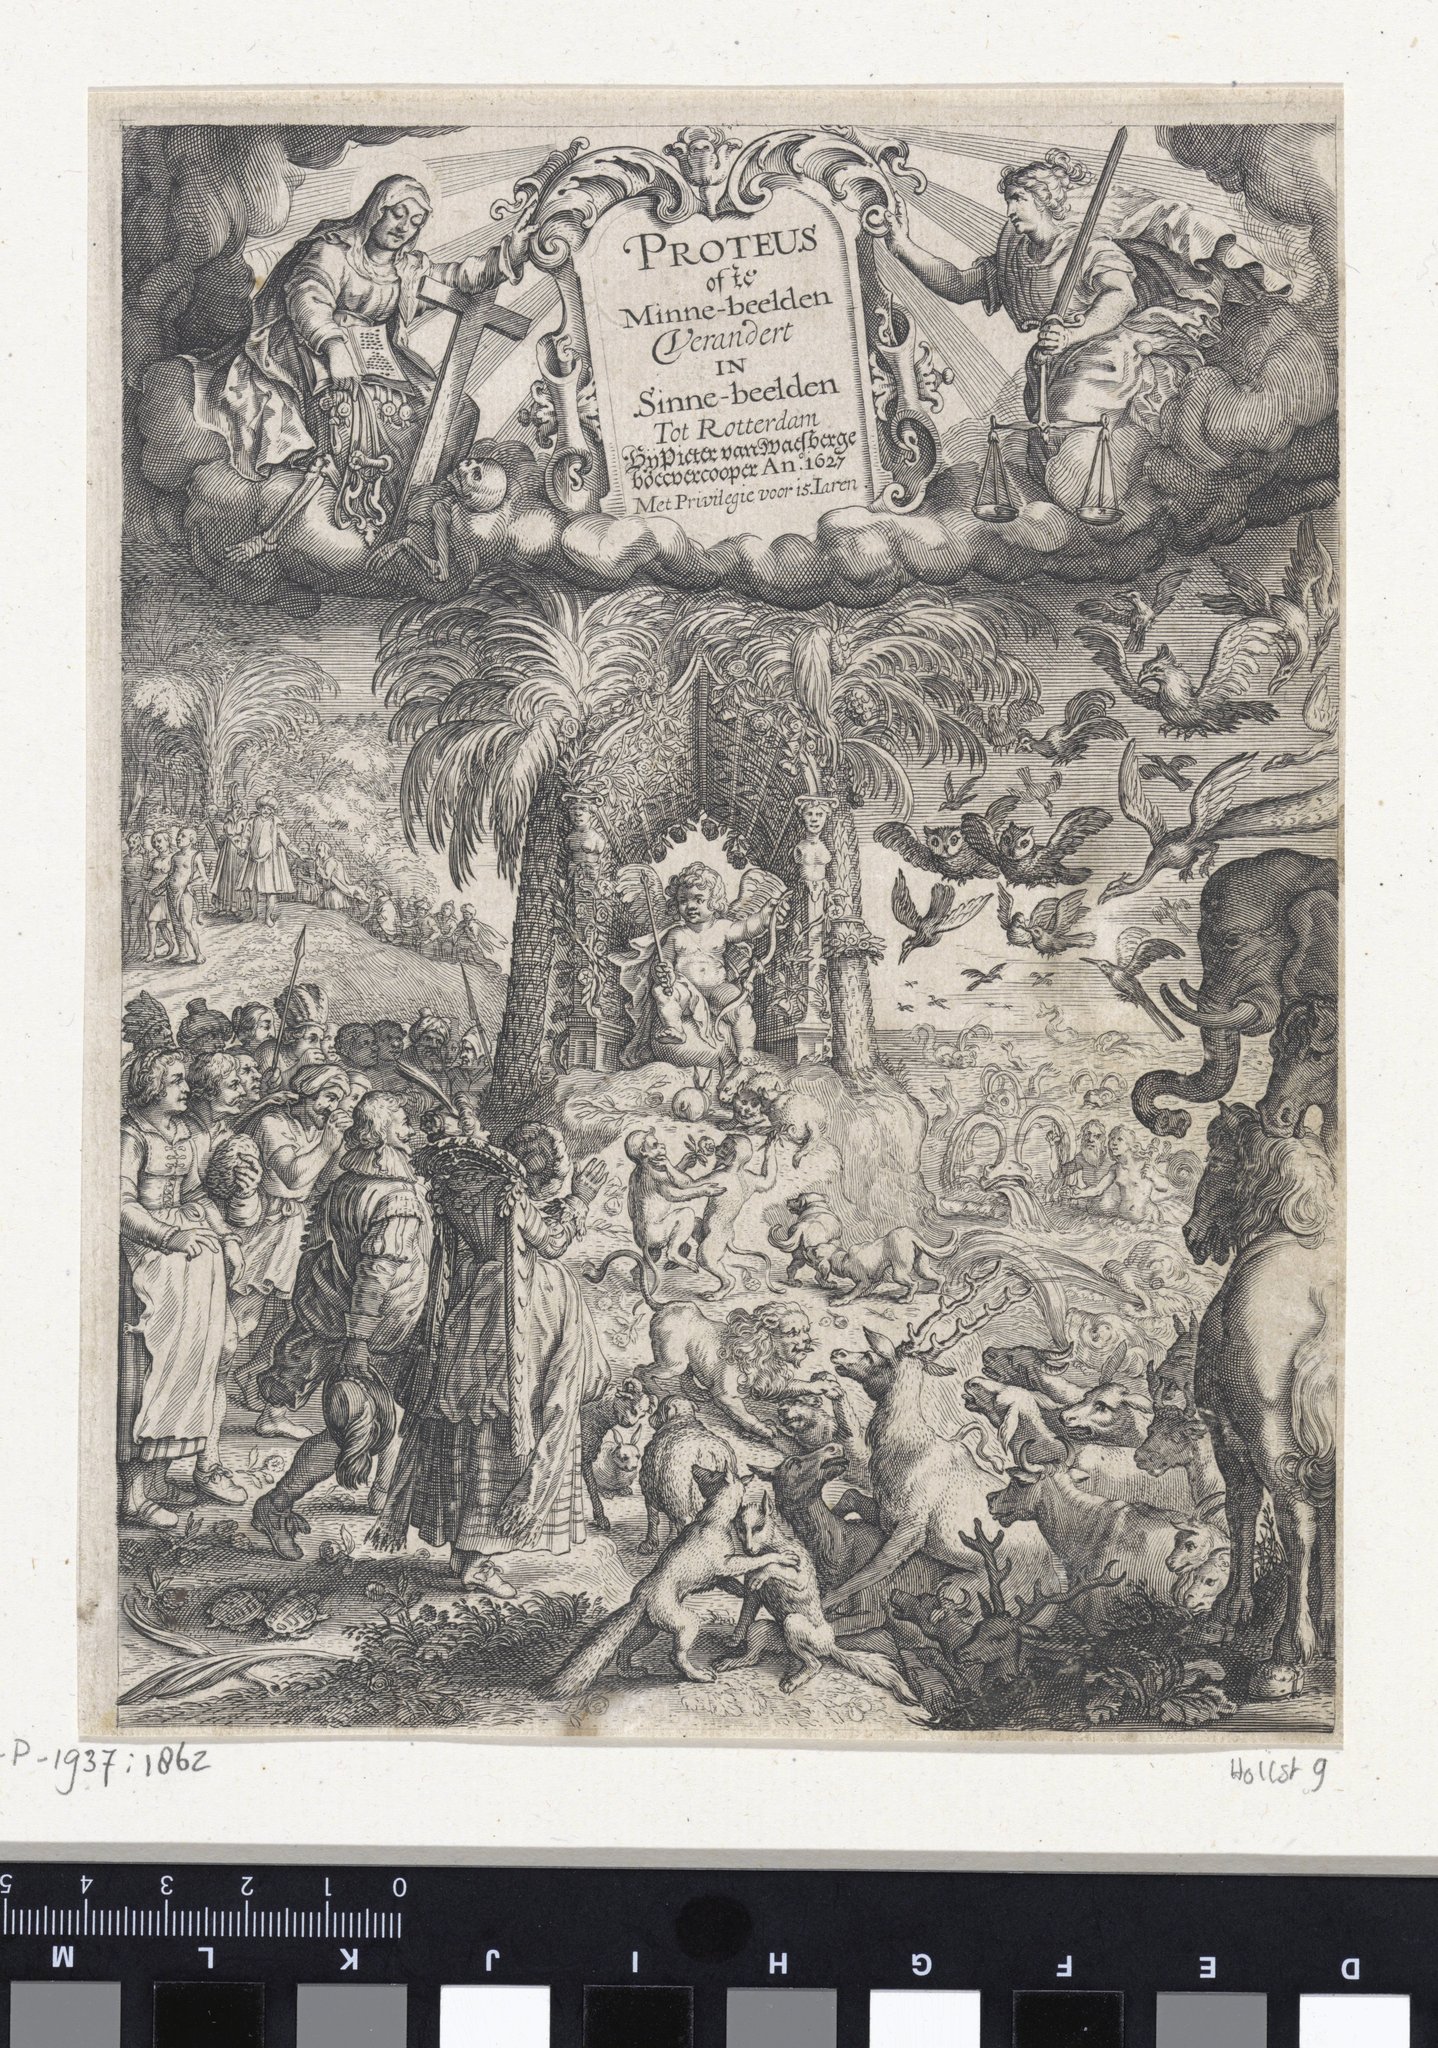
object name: titelblad, titelpagina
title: Titelpagina voor: J. Cats, Proteus, 1627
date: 1627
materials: paper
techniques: engraving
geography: amsterdam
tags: fides (faith) as roman personification, justice, 'justitia'; 'giustitia divina' (ripa) ~ one of the four cardinal virtues, animals, triumph of cupid, death as skeleton, indigenous peoples of north america, head-gear: turban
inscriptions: collector's mark: Lugt 2228, collector's mark: Lugt 2760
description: In een prieeltje omgeven door palmbomen zit Cupido met een scepter en een boog in de hand. Over een heuvel nadert een lange stoet mensen, eenvoudig en rijk gekleed, maar ook in buitenlandse kostuums als tulbanden, verentooien of niets verhullende lendendoeken. Van de andere kant komen dieren, steeds paarsgewijs. Ze stoeien aan de voeten van Cupido. Vanaf zee naderen dolfijnen, walvissen en fantasiecreaturen. In de lucht vliegen vogels. Twee allegorische vrouwenfiguren op een wolk, voorstellende Geloof en Recht, houden een bord op waarop de titel van het boek en het impressum staan vermeld. Geloof vertrapt de dood onder haar voeten.